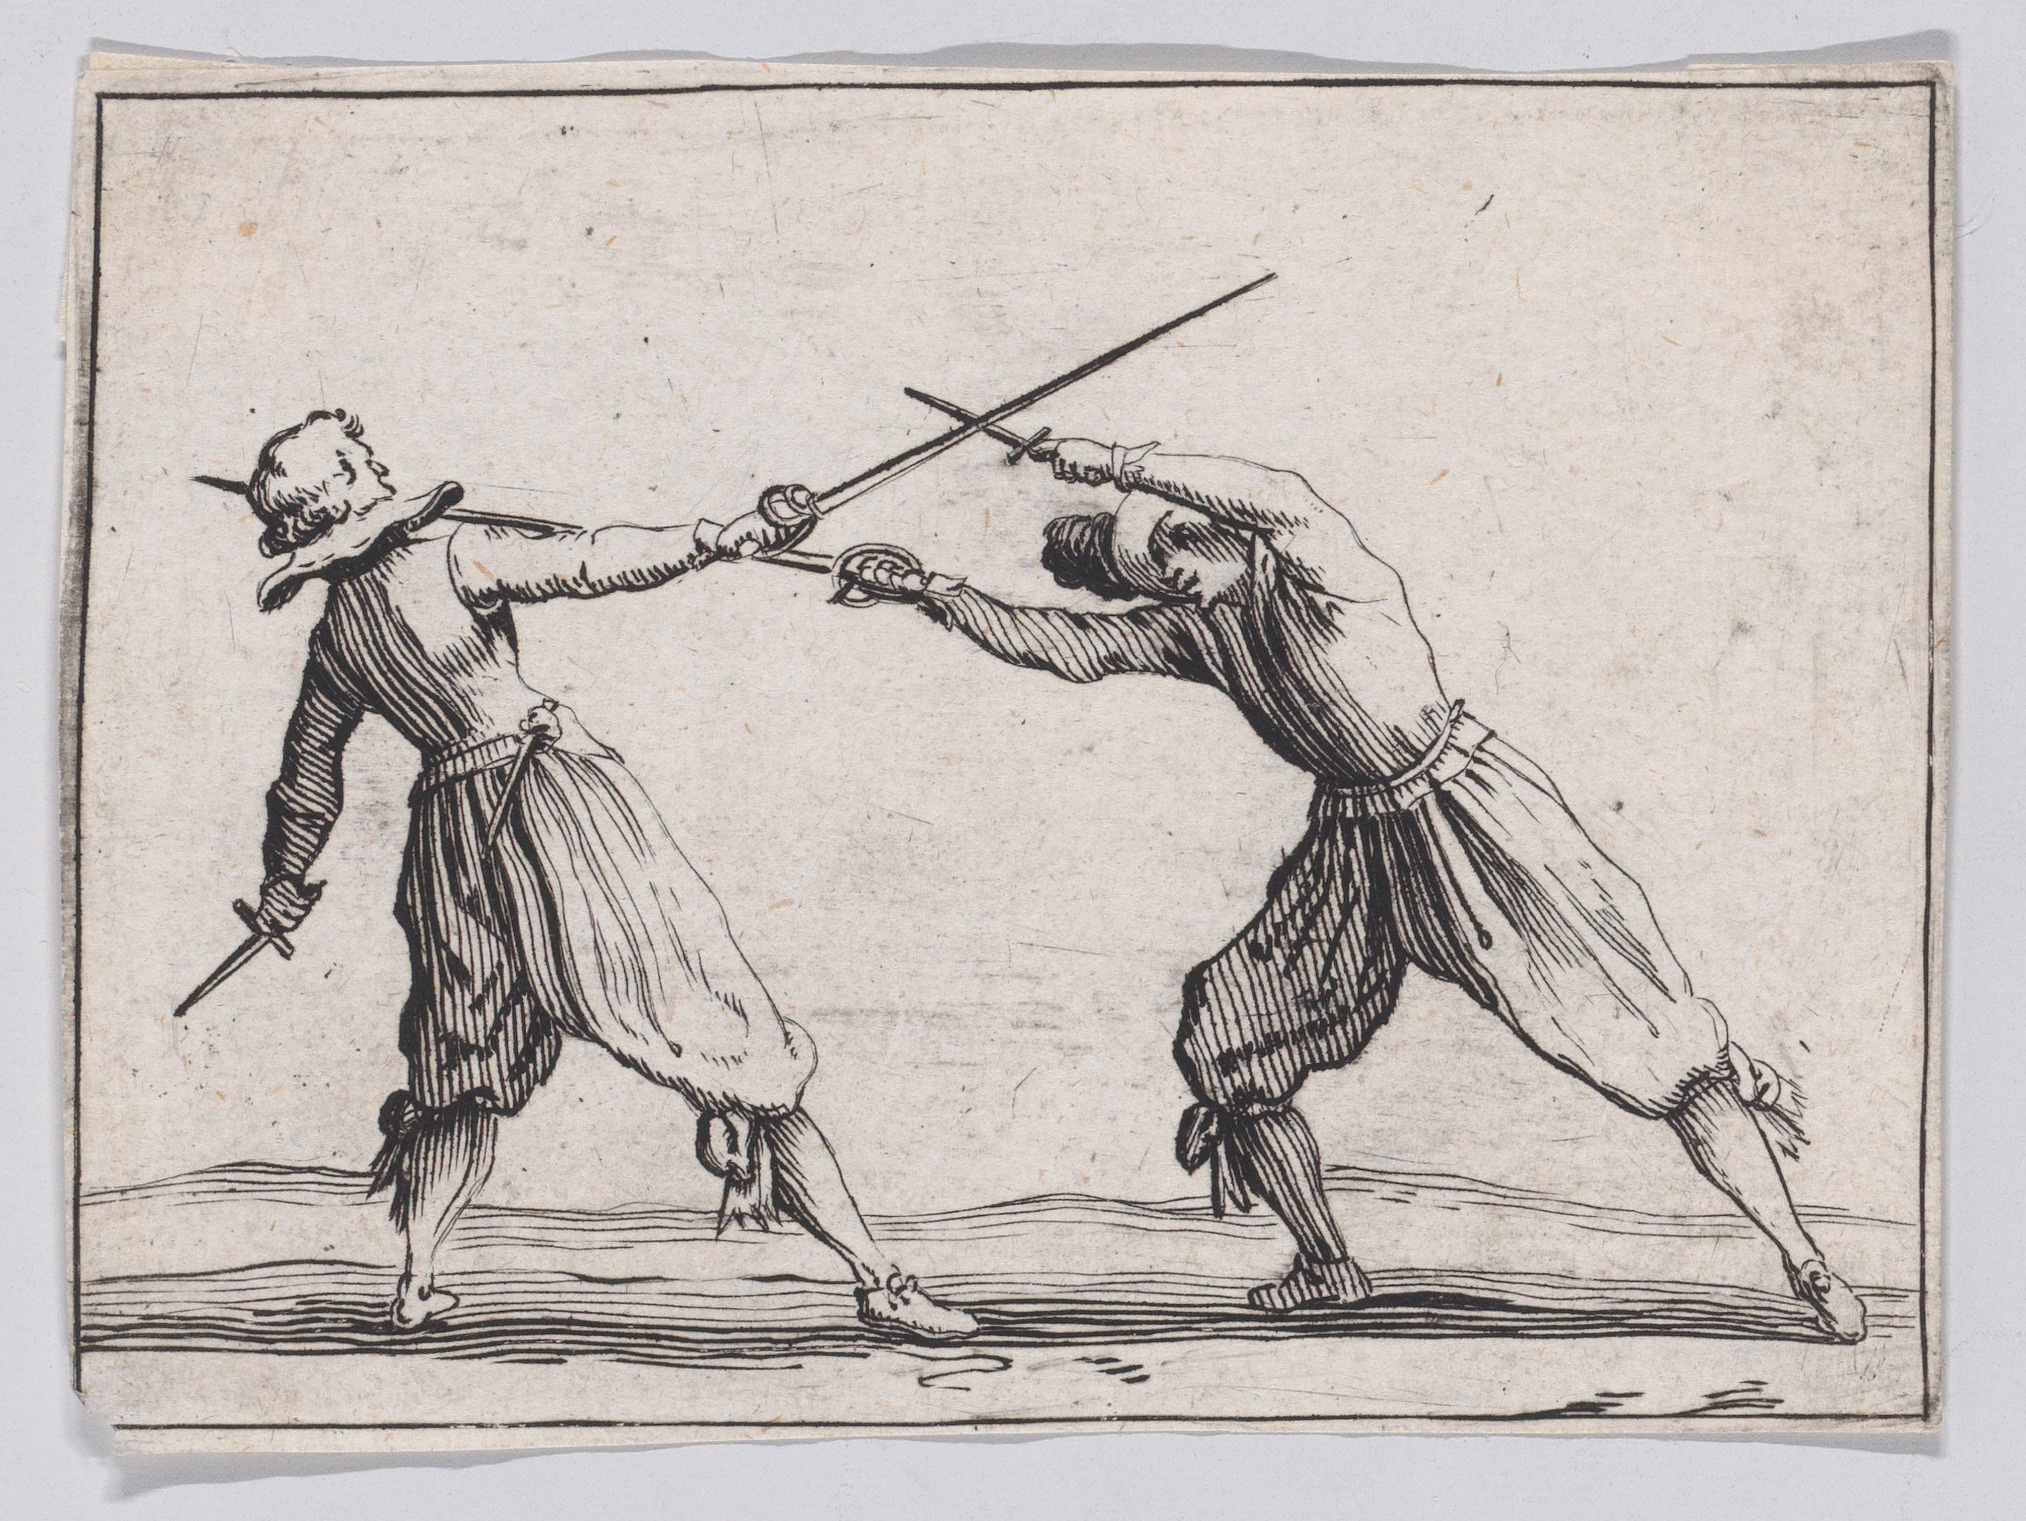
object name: print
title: Copy of Le Duel a l'Épée et au Poignard (The Duel with the Sword and Dagger), from "Les Caprices"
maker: Anonymous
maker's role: artist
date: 1601-1700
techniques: etching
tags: swords,men